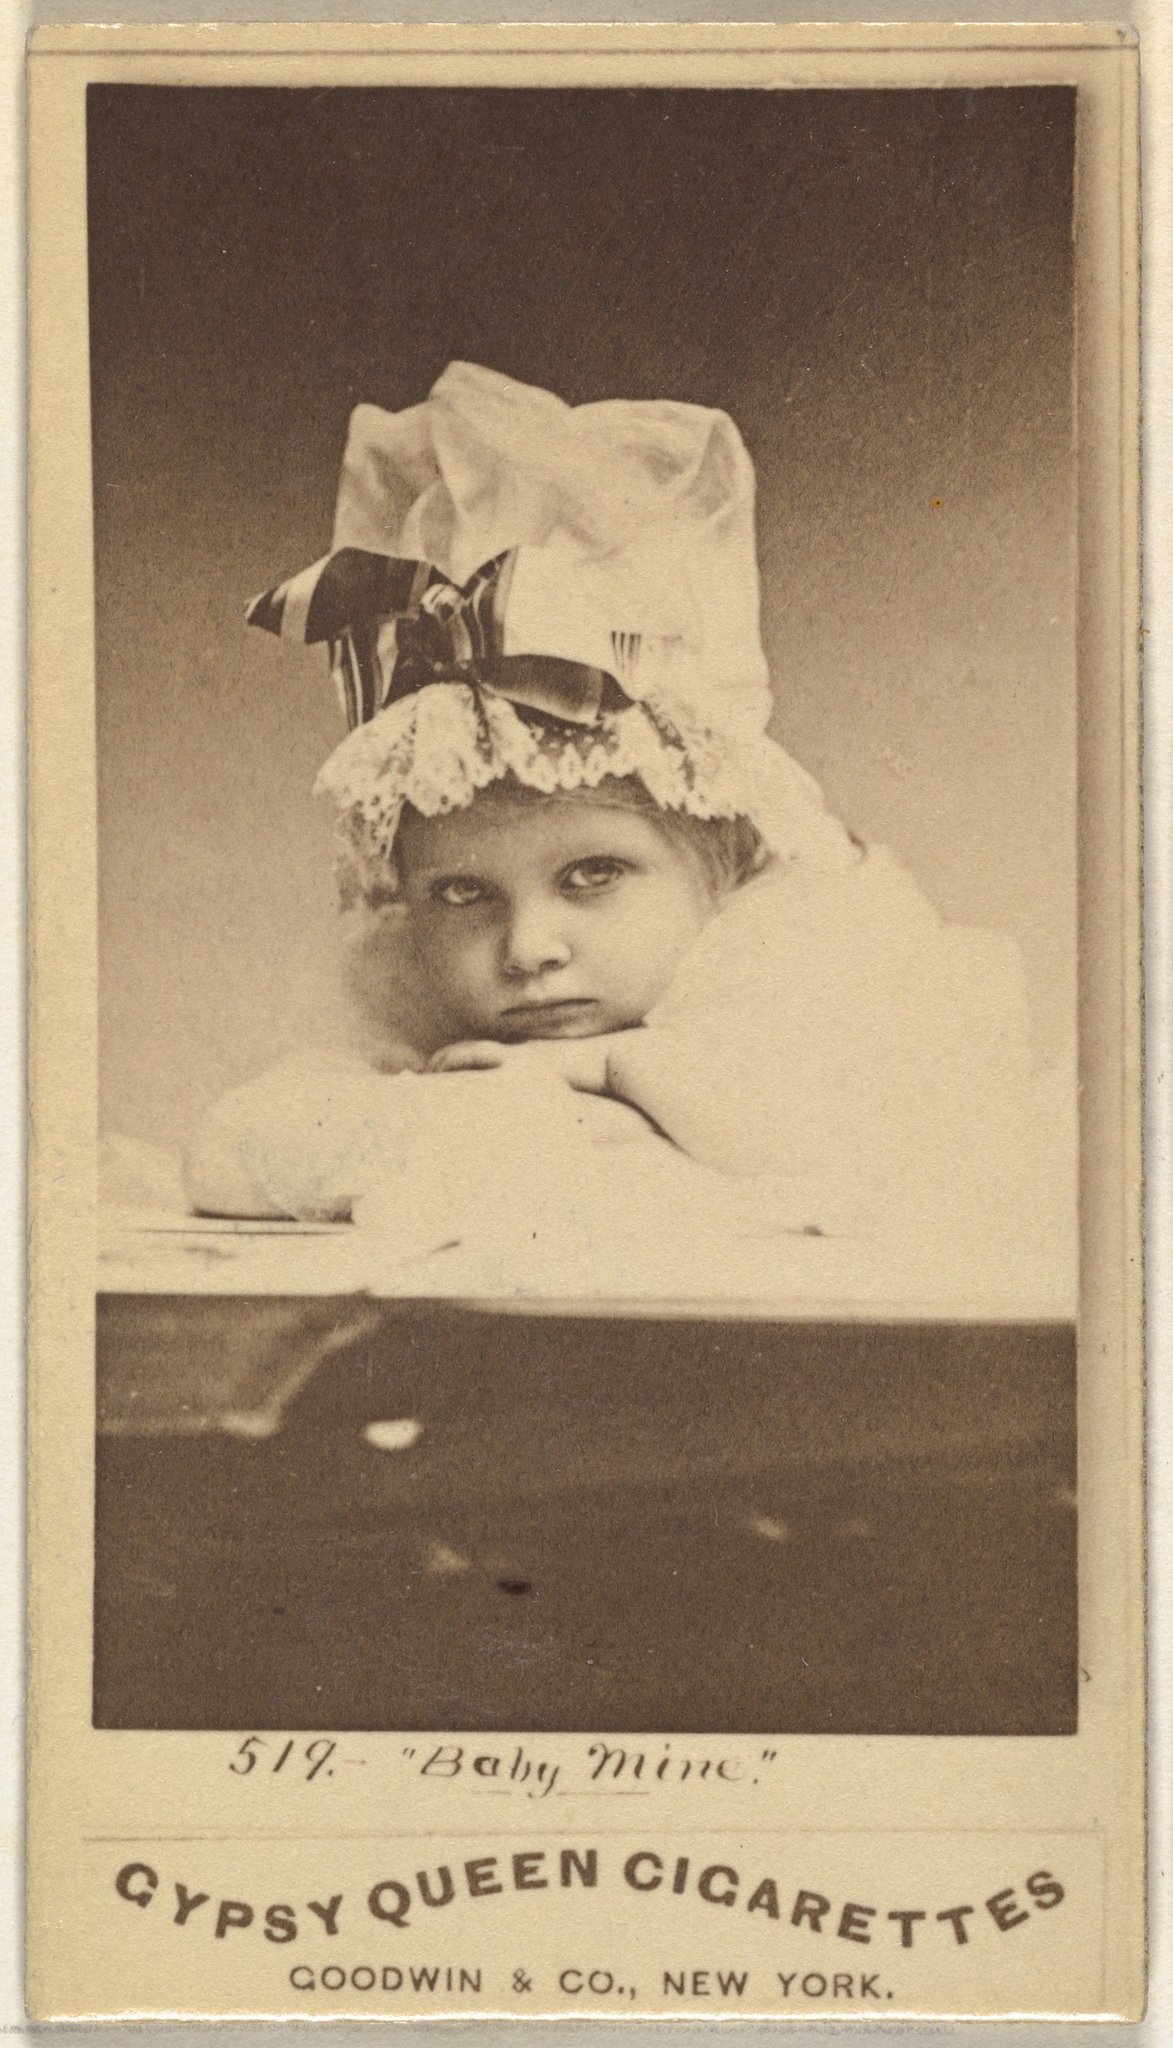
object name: photograph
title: "Baby Mine", from the Actors and Actresses series (N171) for Old Judge Cigarettes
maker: goodwin & company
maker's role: publisher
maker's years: 1850-1950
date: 1886-1890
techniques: albumen silver print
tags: girls,portraits,actresses